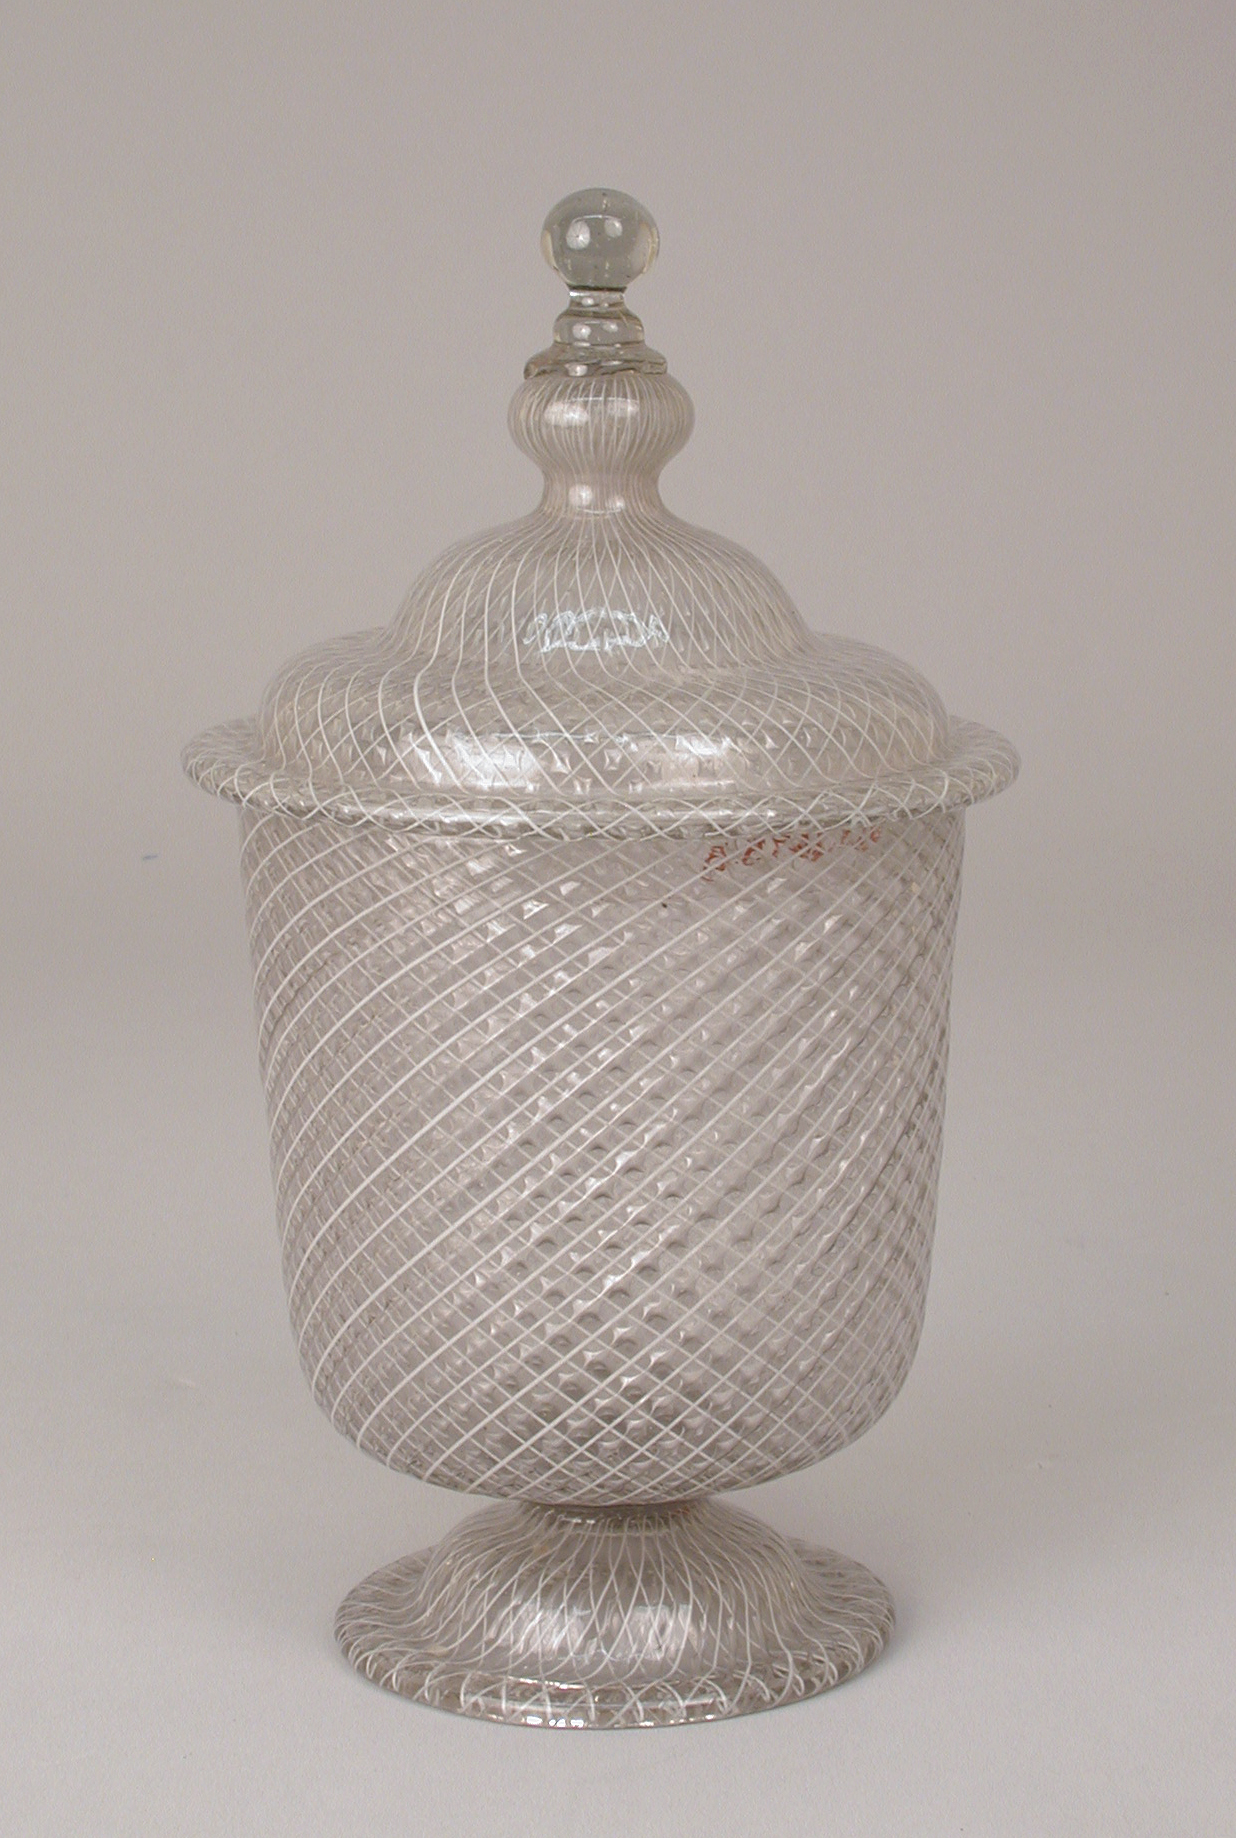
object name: jar with cover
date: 1501-1600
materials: glass